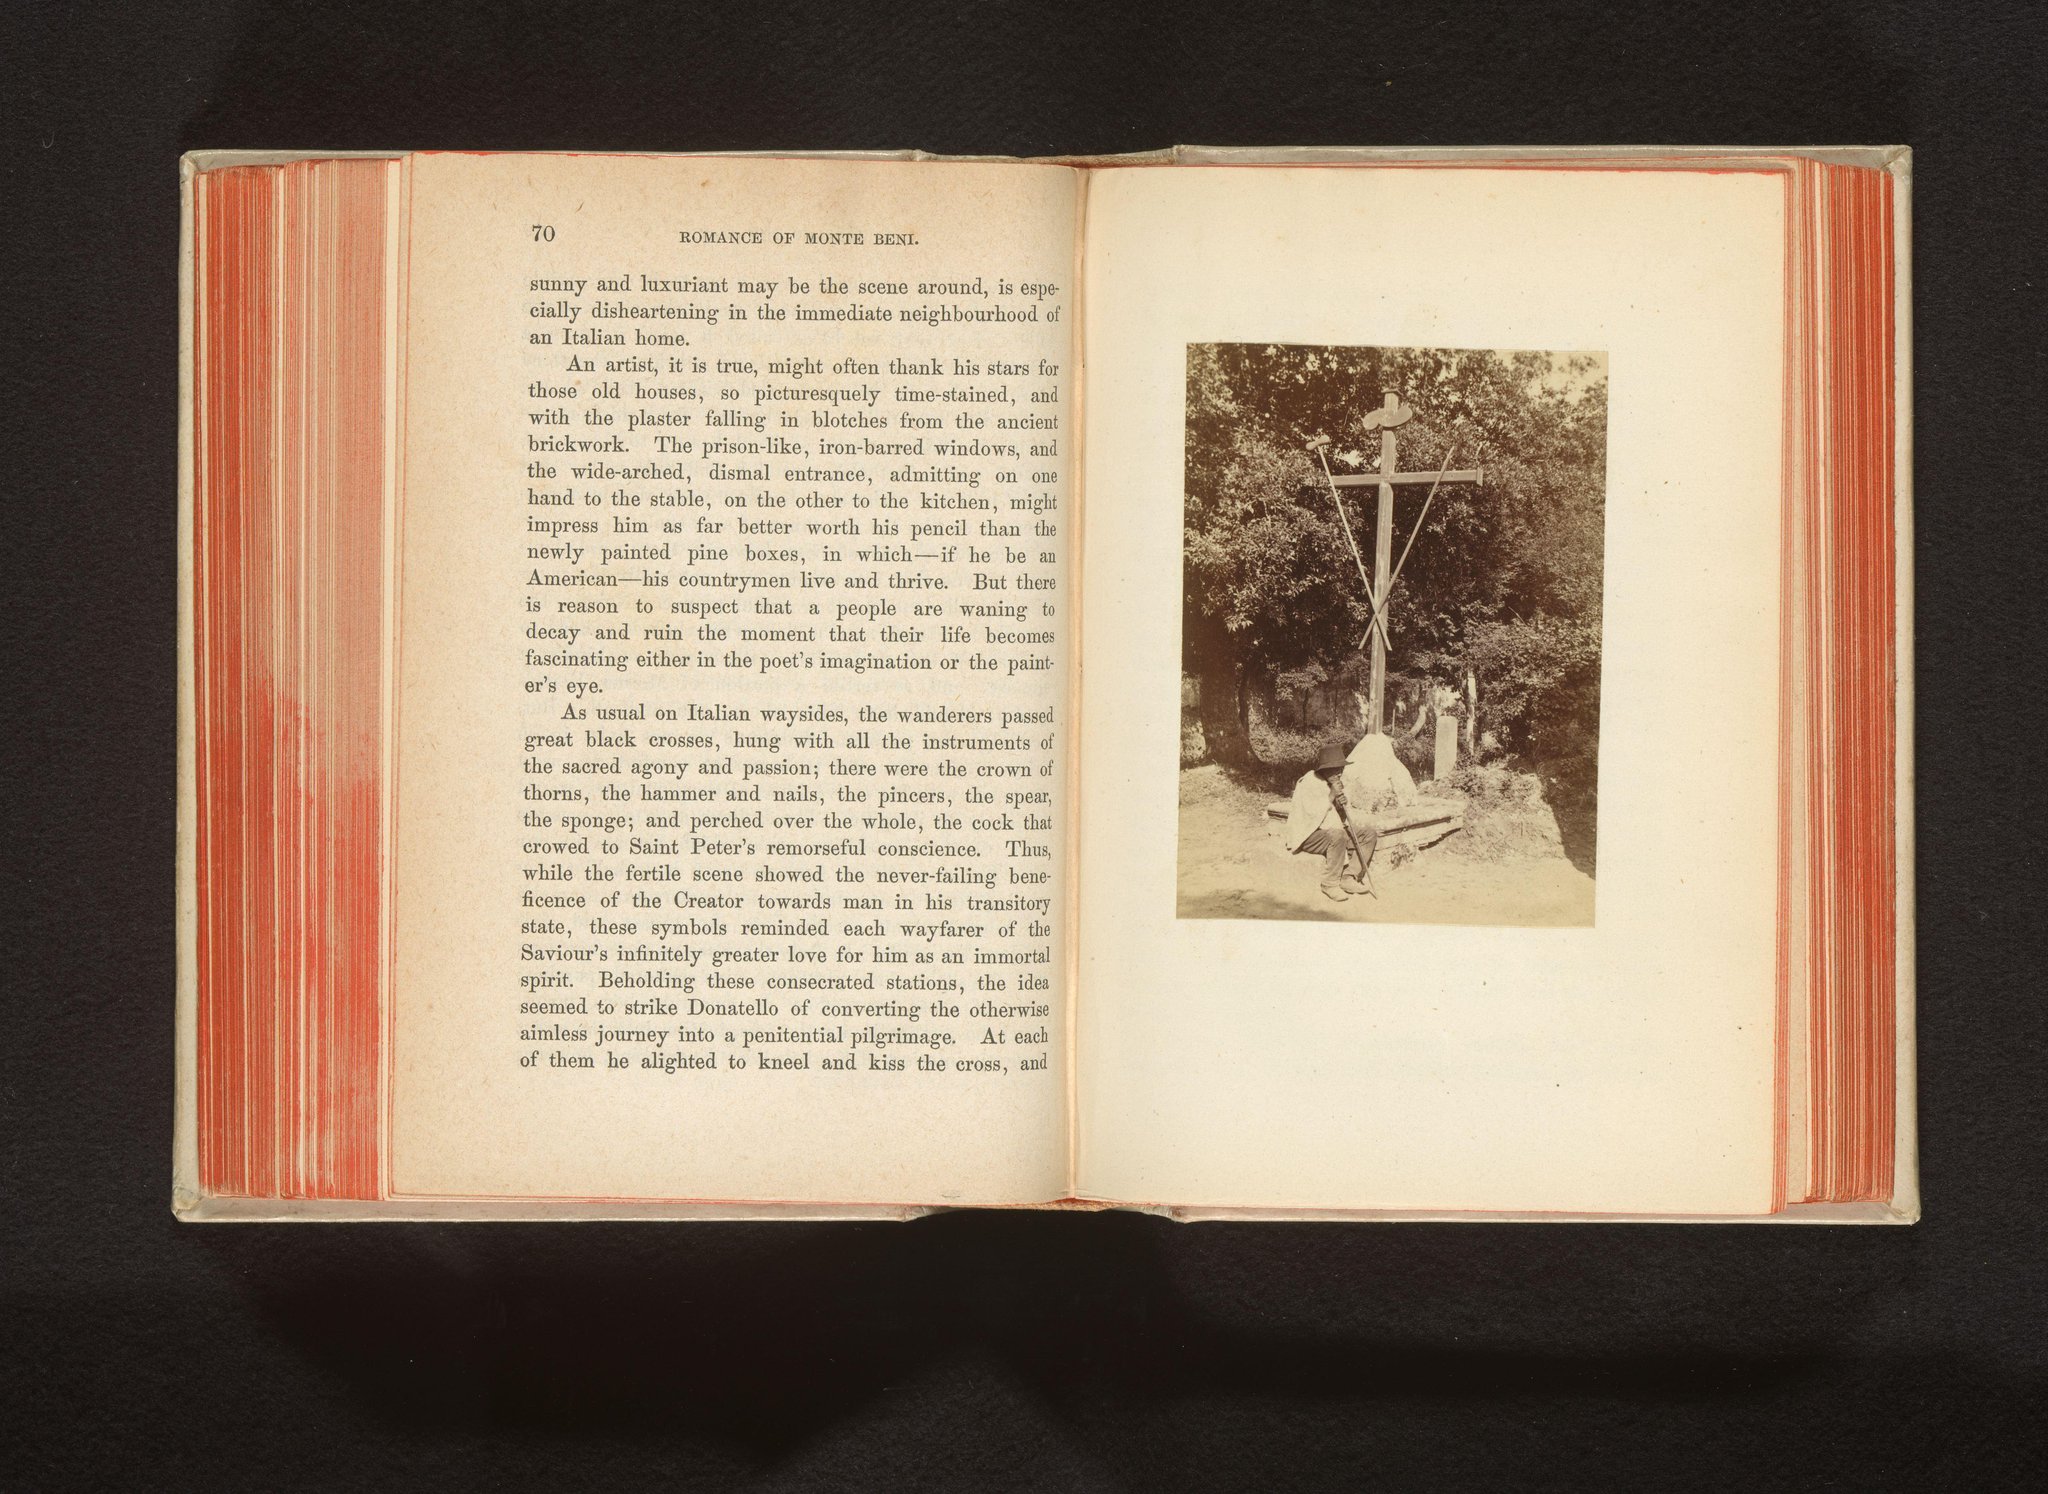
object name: photograph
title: Man zittend bij een kruis voor een boom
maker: Anonymous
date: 1850-1860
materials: photographic support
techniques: albumen print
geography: italy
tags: cross as symbol of christ